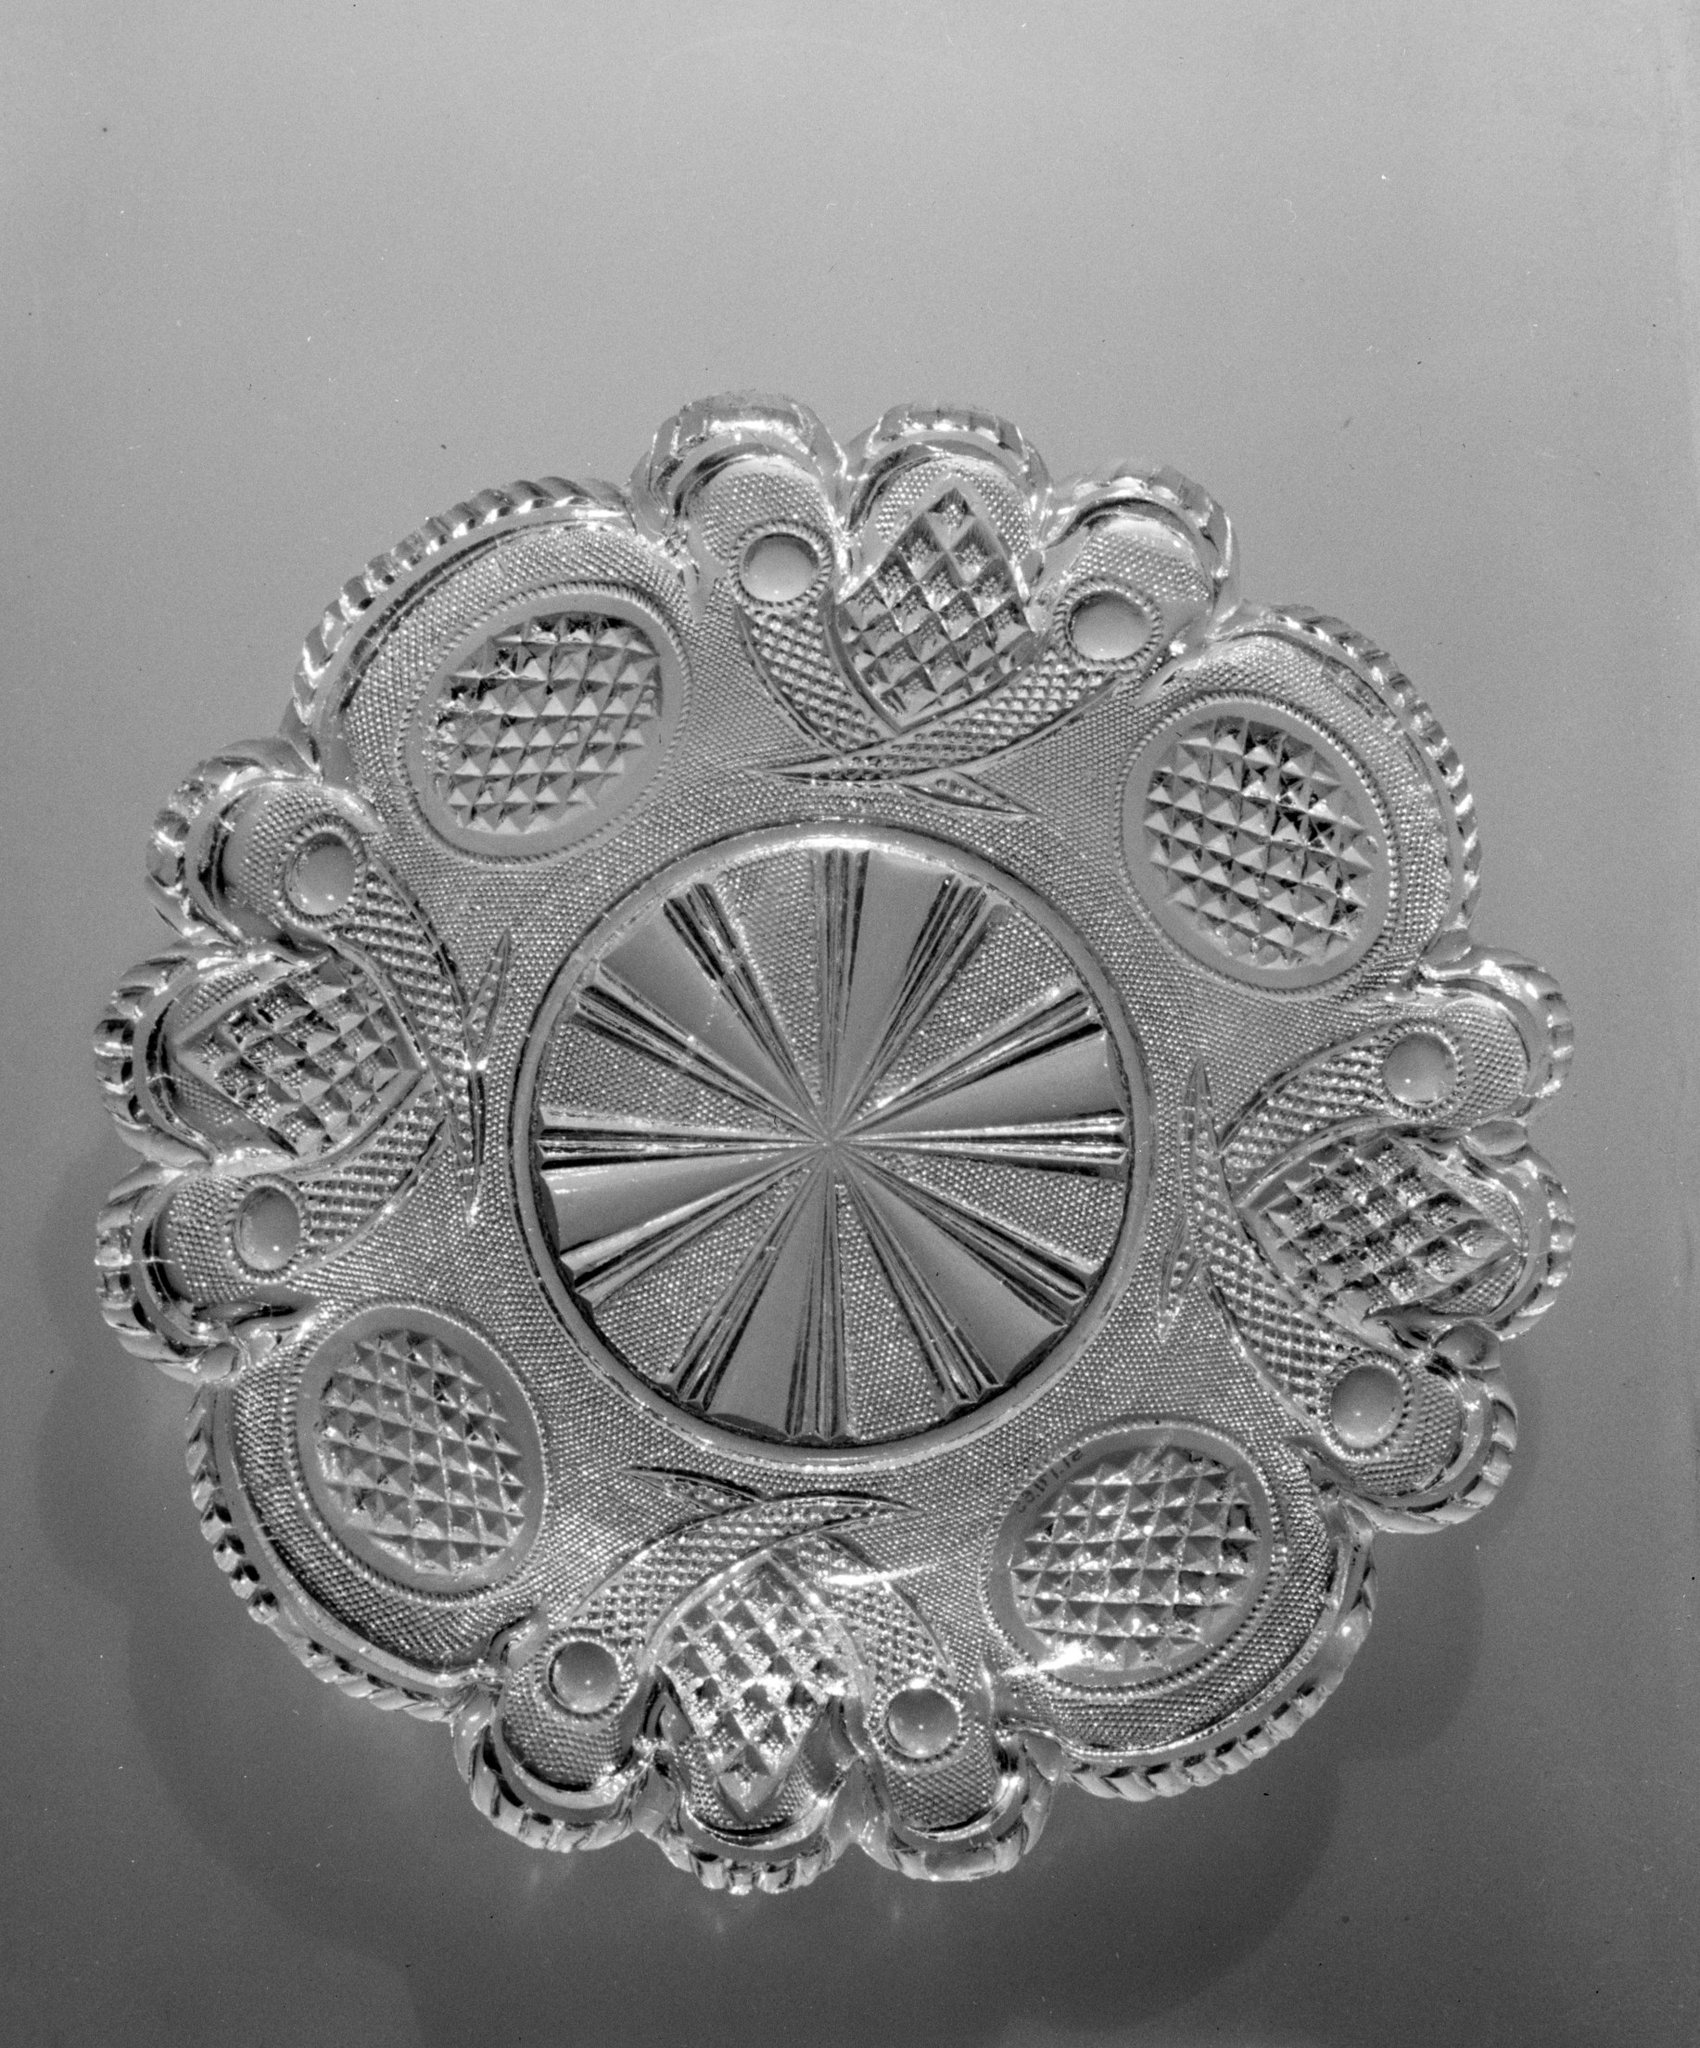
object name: dish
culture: american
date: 1835-1840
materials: glass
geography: united states